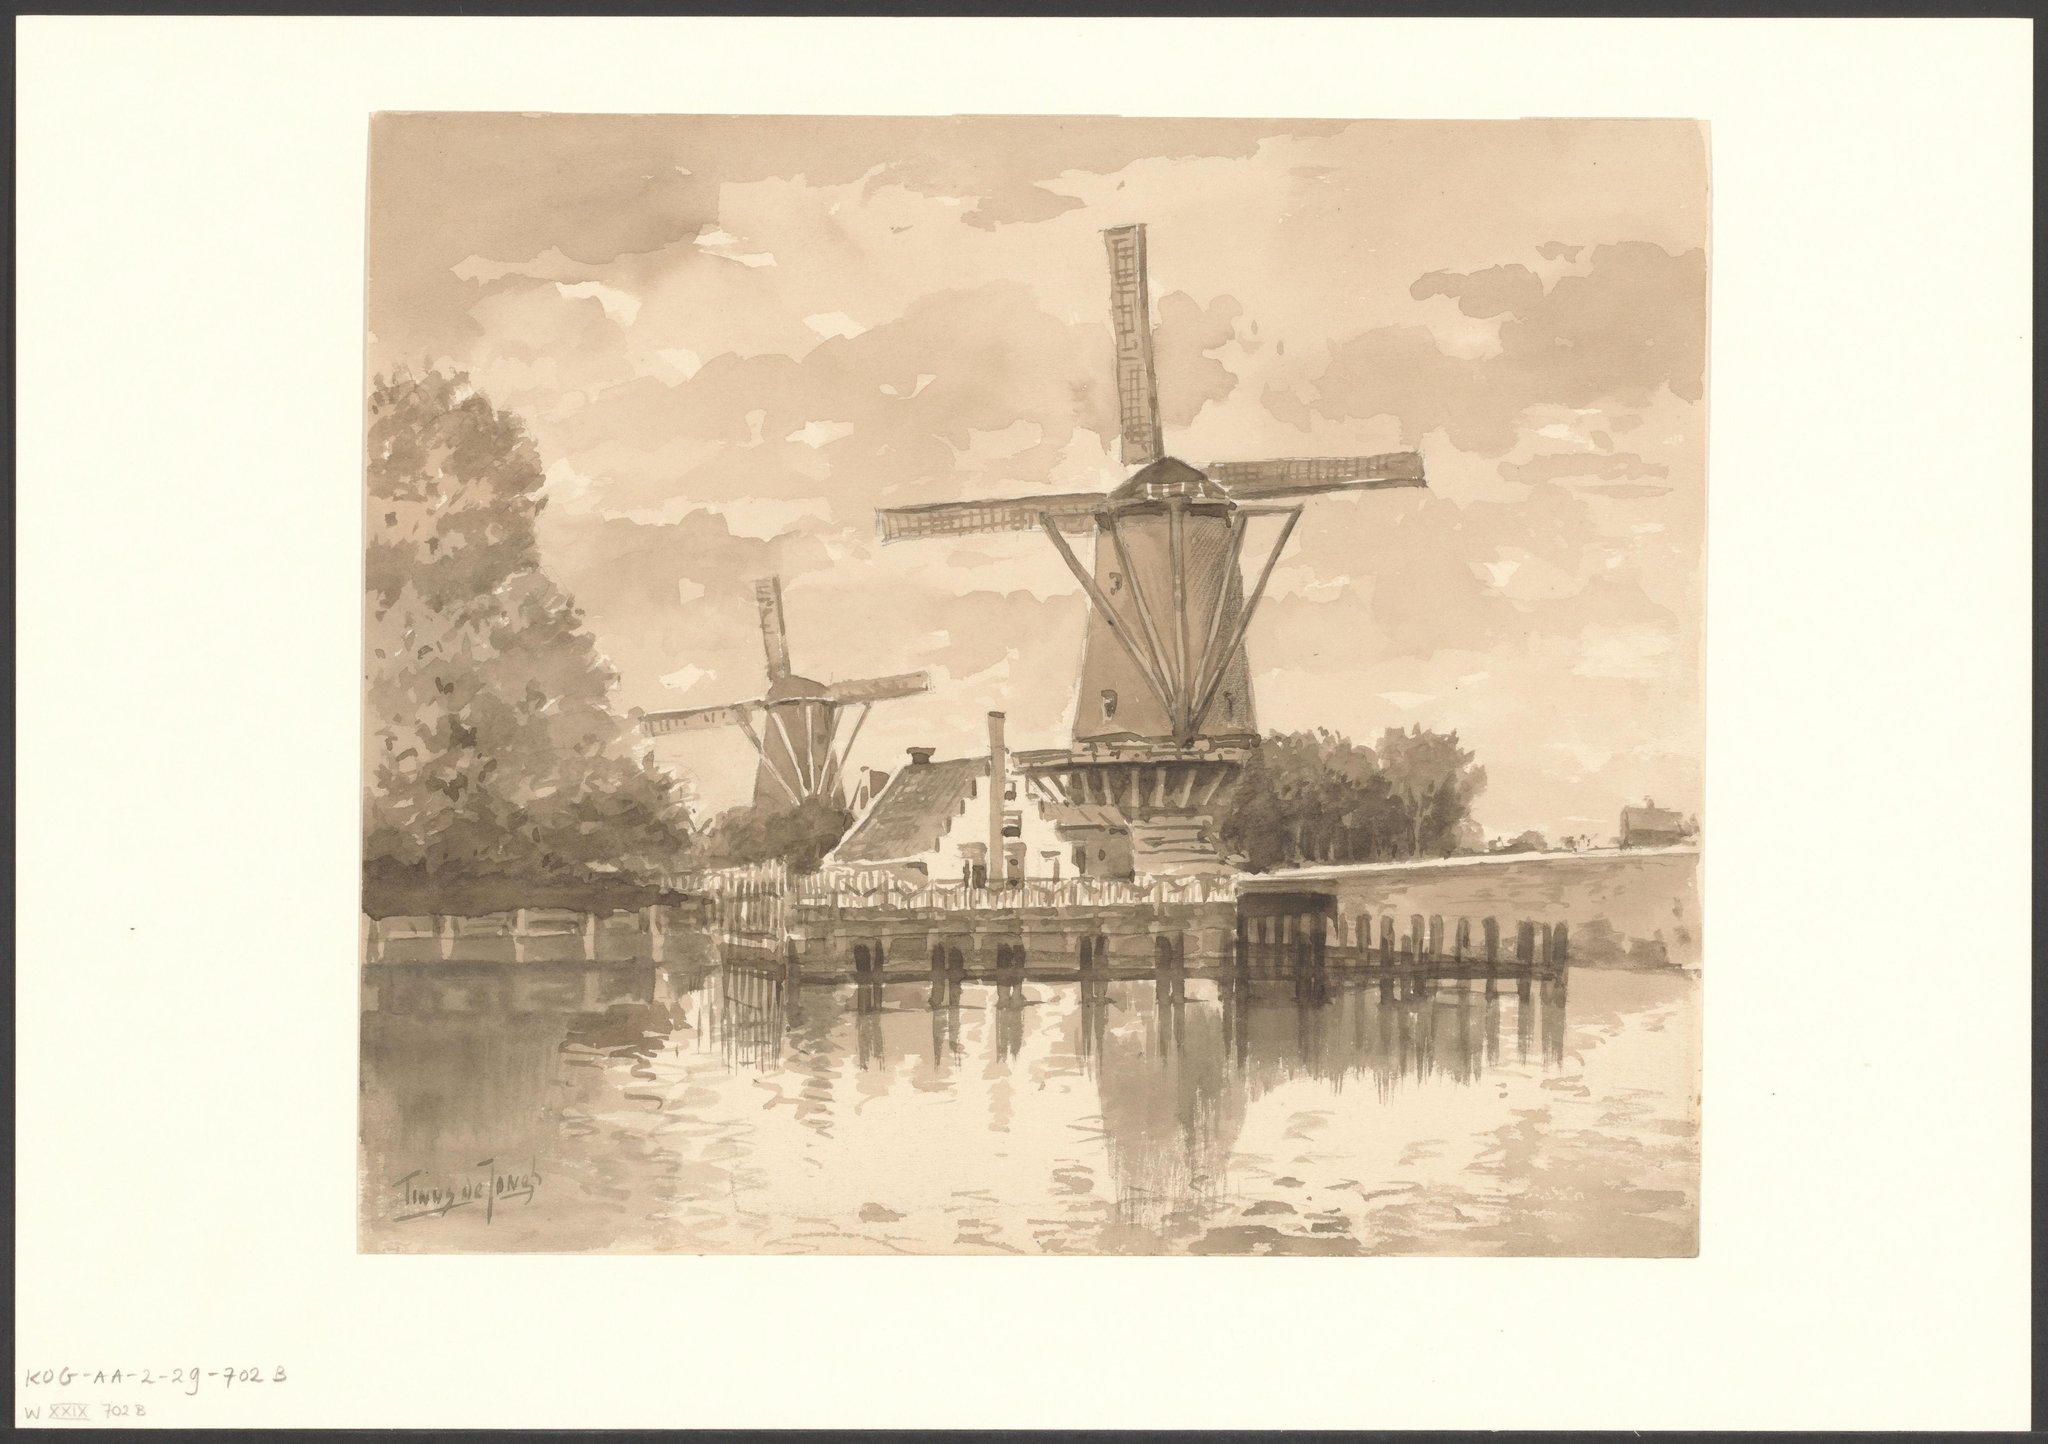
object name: drawing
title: Gezicht op een molen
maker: tinus de jongh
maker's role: print maker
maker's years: 1885-1942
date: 1895-1942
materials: ink, paper, pencil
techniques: brush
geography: amsterdam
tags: city-view in general; 'veduta', canal, windmill in landscape, amsterdam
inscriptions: signature: ‘Tinus de Jongh’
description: Tekening binnen de Atlas Van Eck ingedeeld op wijknummer 29.